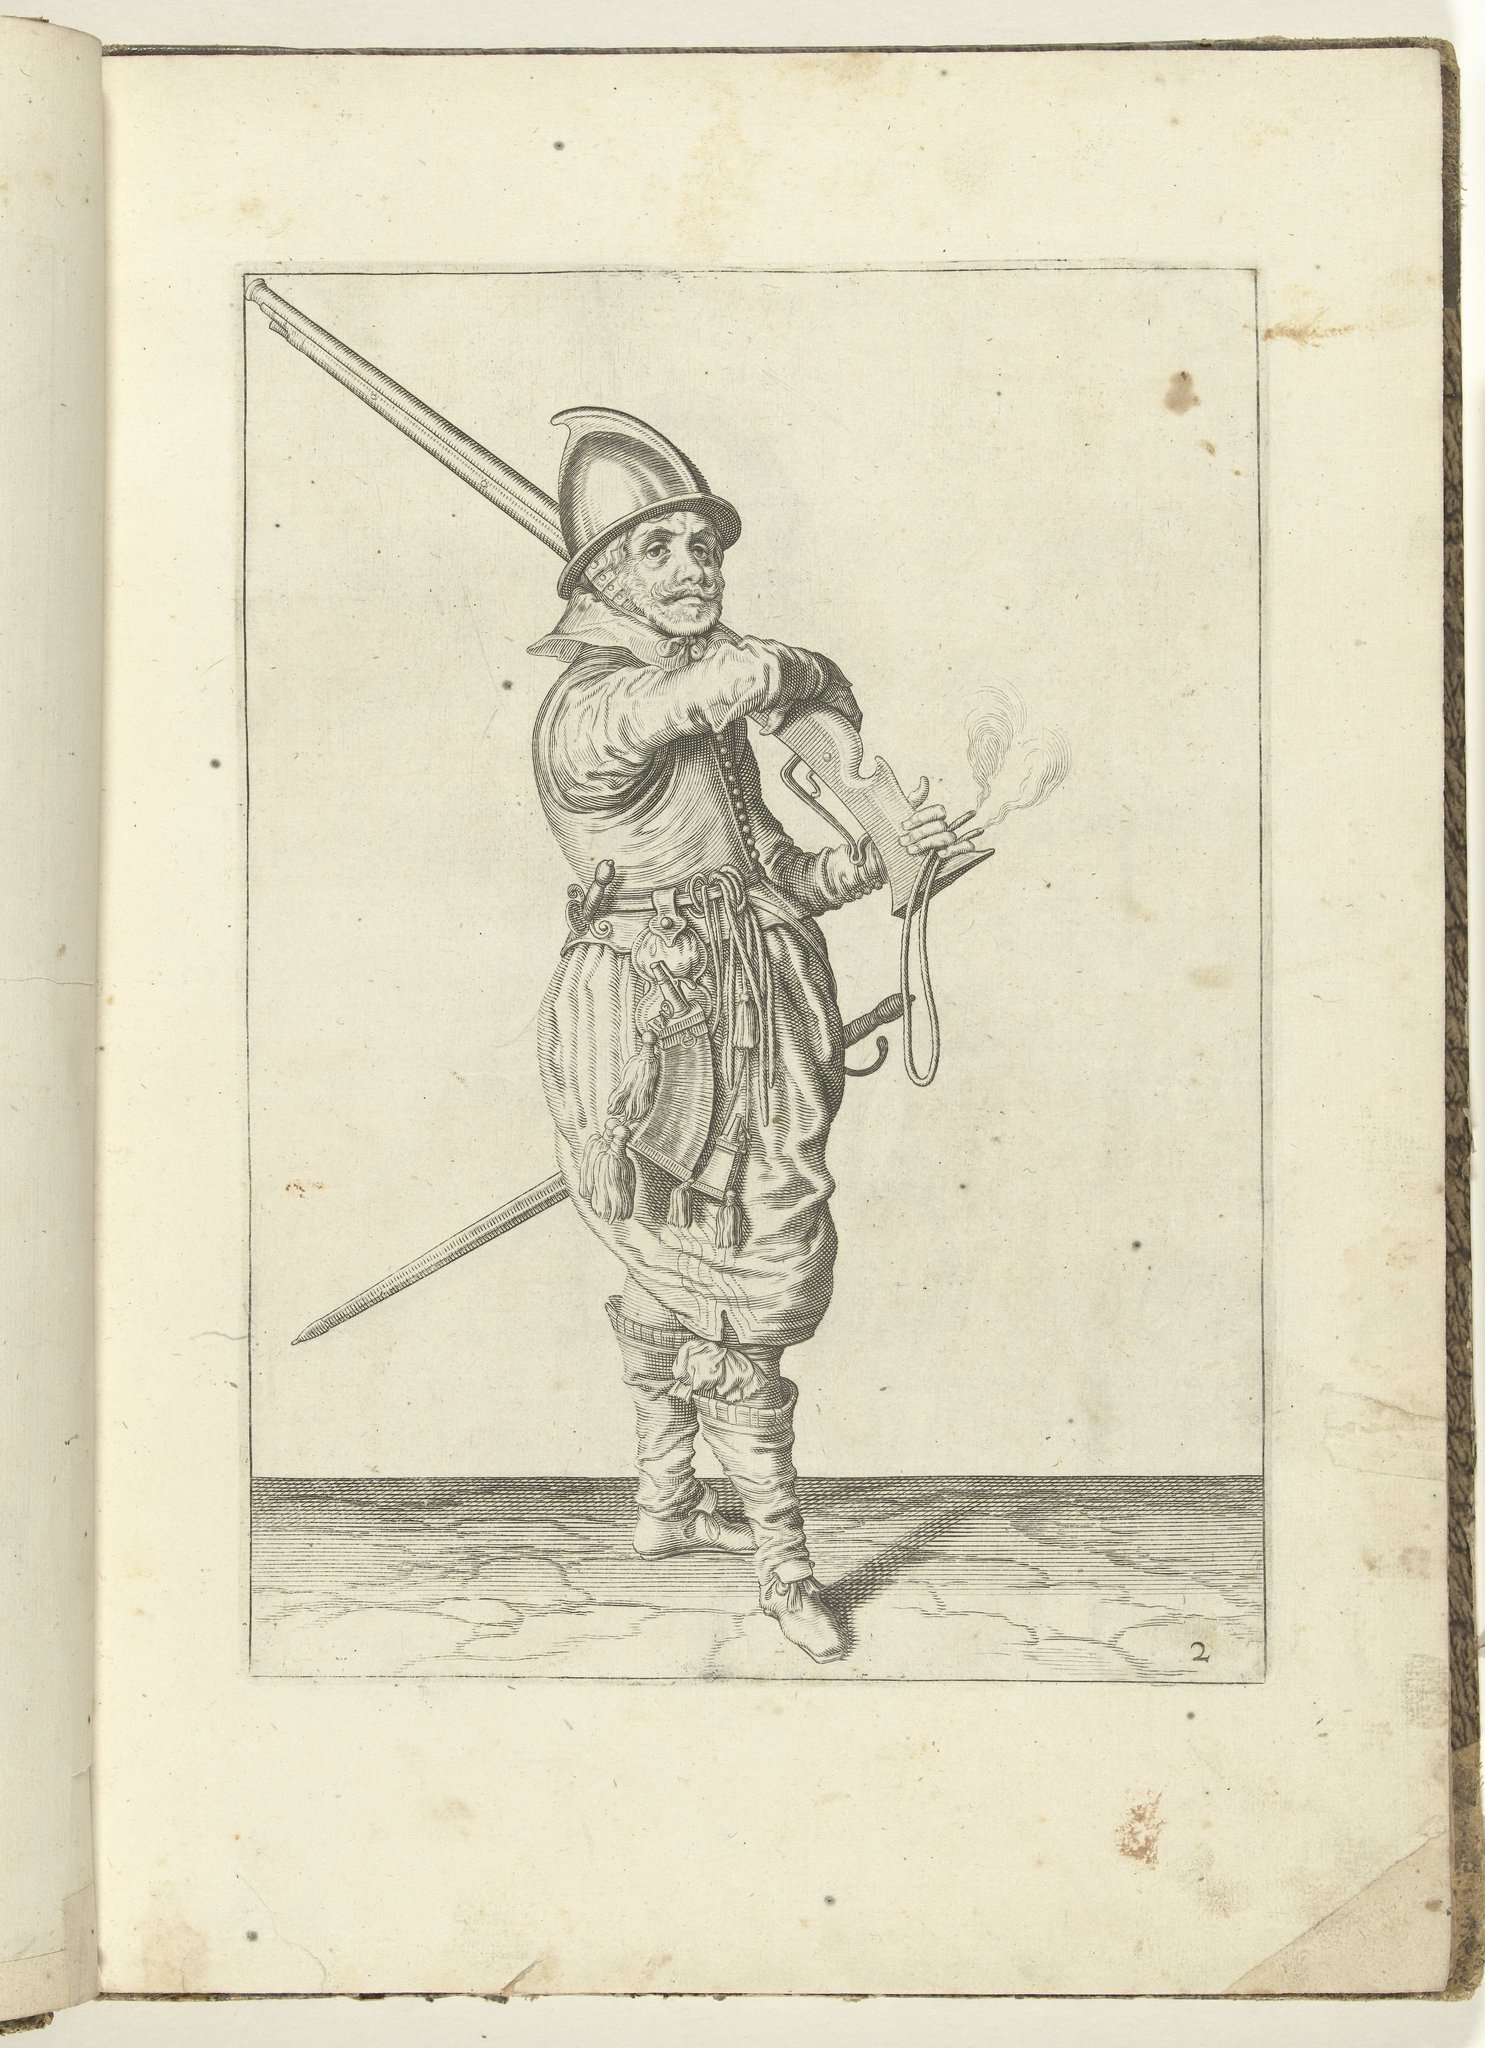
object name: print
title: Soldaat die zijn roer van zijn schouder neemt (nr. 2), ca. 1600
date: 1597-1608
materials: paper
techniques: engraving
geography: northern netherlands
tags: maurice (prince of orange), handling of weapons ~ military training, weapons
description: Een soldaat, ten voeten uit, naar rechts, die een roer (een bepaald type vuurwapen) van zijn linkerschouder neemt met zijn rechterhand (nr. 2), ca. 1600. In zijn linkerhand behalve de kolf van het roer ook een brandende lont. Plaat 2 in de instructies voor het hanteren van de roer: Brief enseignement, sur la representation des figures, du droit maniement de l'Harquebuse. Onderdeel van de illustraties in een Franse editie van J. de Gheyns Wapenhandelinghe: J. de Gheyn, Maniement d'armes, d'arquebuses, mousquetz et piques : en conformité de l'ordre de Mour le Prince Maurice, Prince d'Orange, Amsterdam 1608. Krijgswezen rond 1600.